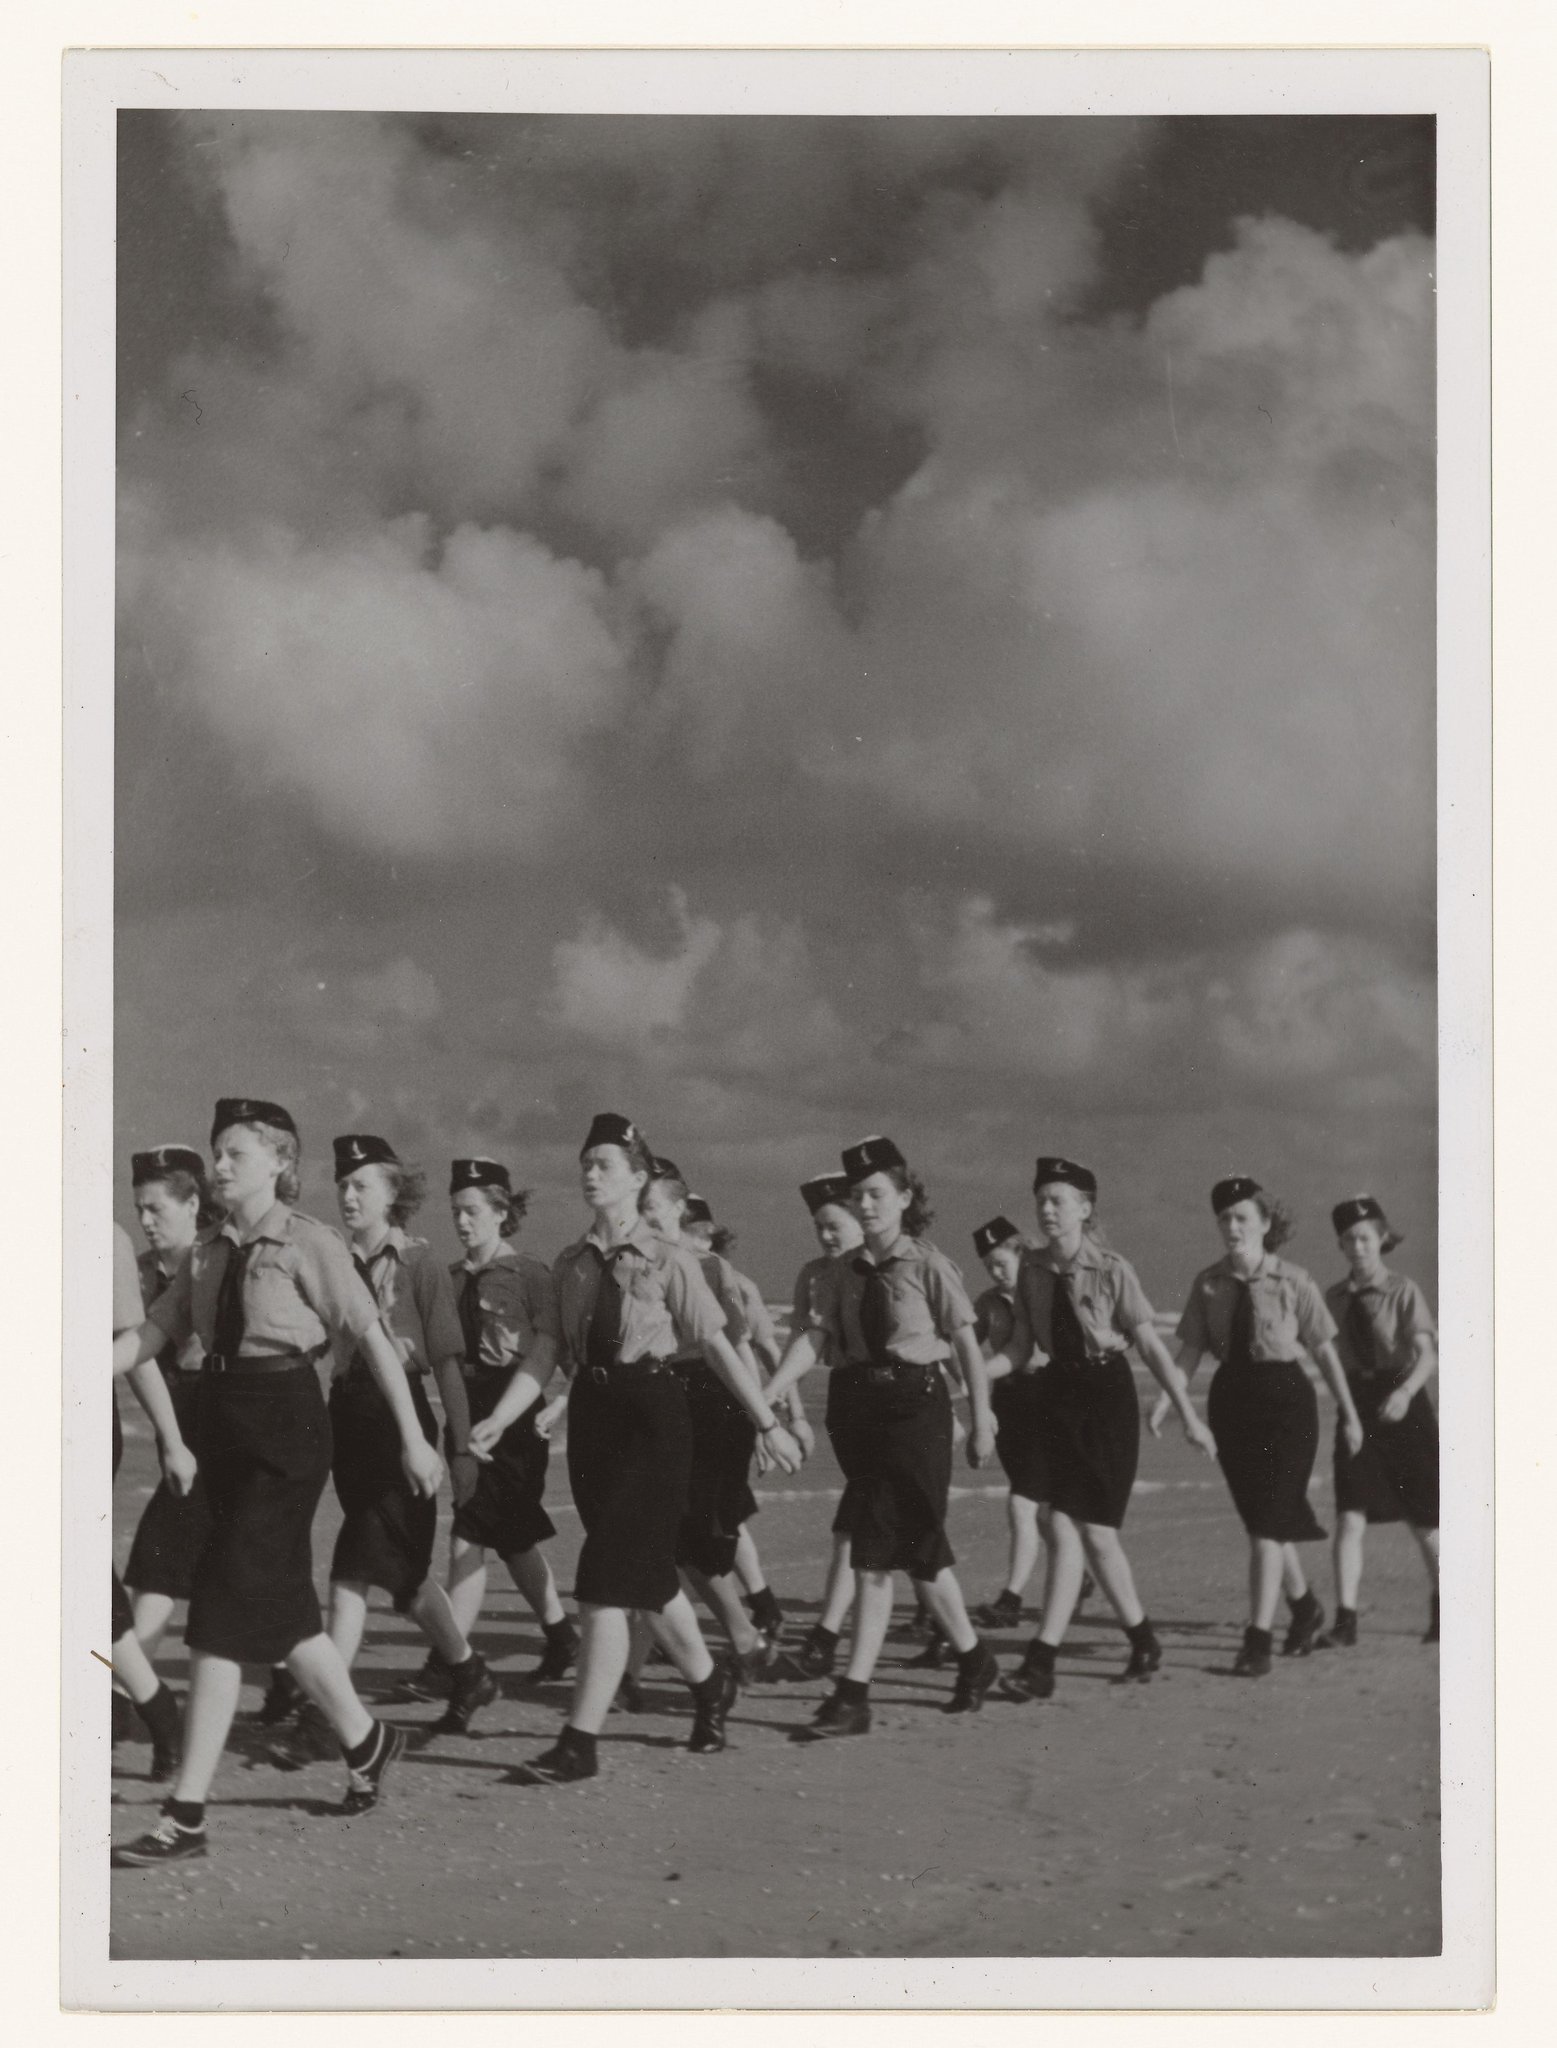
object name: photograph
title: Jeugdstorm wandelt langs het strand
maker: j.h. hasewinkel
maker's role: fotograaf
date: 1903-1942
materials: photographic support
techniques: gelatin silver print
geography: zandvoort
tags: military training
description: Een groep meisjes van de Jeugdstorm wandelt in uniform langs het strand van Zandvoort en zingt. Gezien de kleding is het zomer.